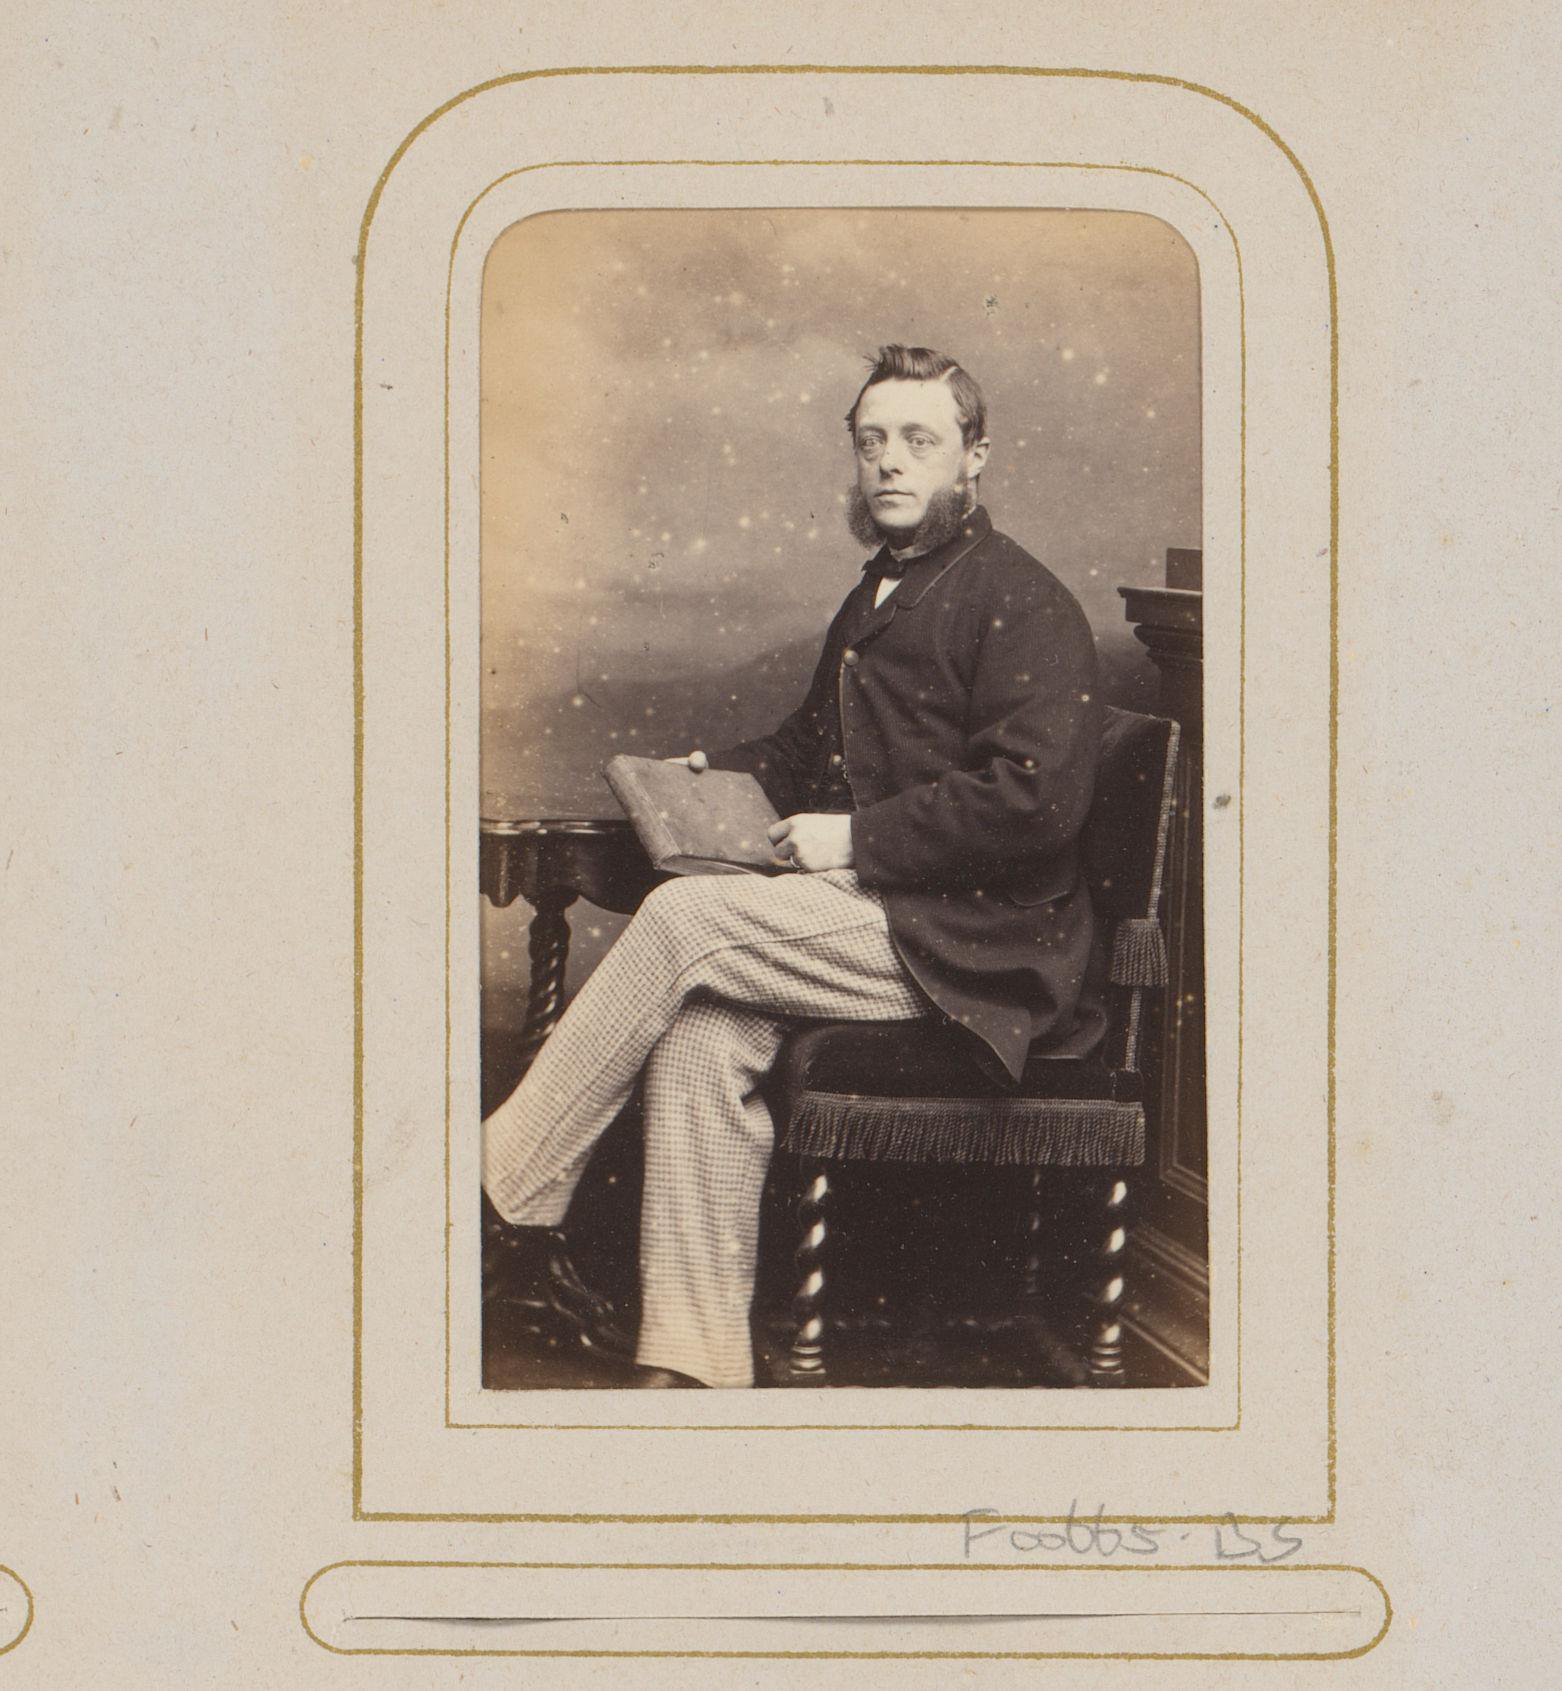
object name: album leaf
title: Portret van een man met boek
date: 1865-1890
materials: cardboard, photographic support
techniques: albumen print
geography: amsterdam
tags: historical persons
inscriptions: inscription: ‘Photogr Atelier/ Wegner & Mottu/ Kalverstraat/ Over den Heyligenweg D.26/ Amsterdam’